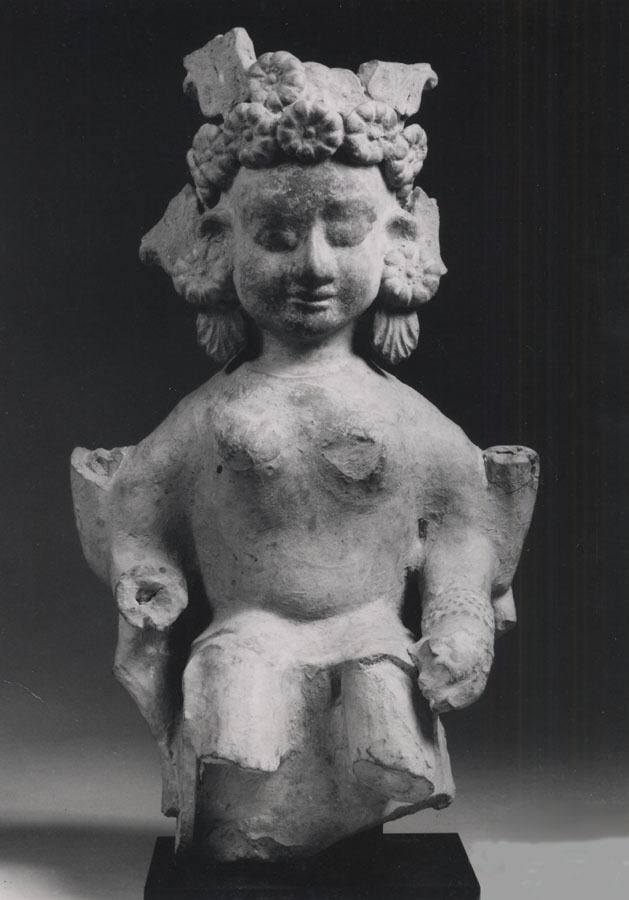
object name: figure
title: Seated Female Goddess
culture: indonesian, javanese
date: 1401-1500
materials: paint, terracotta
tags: goddess